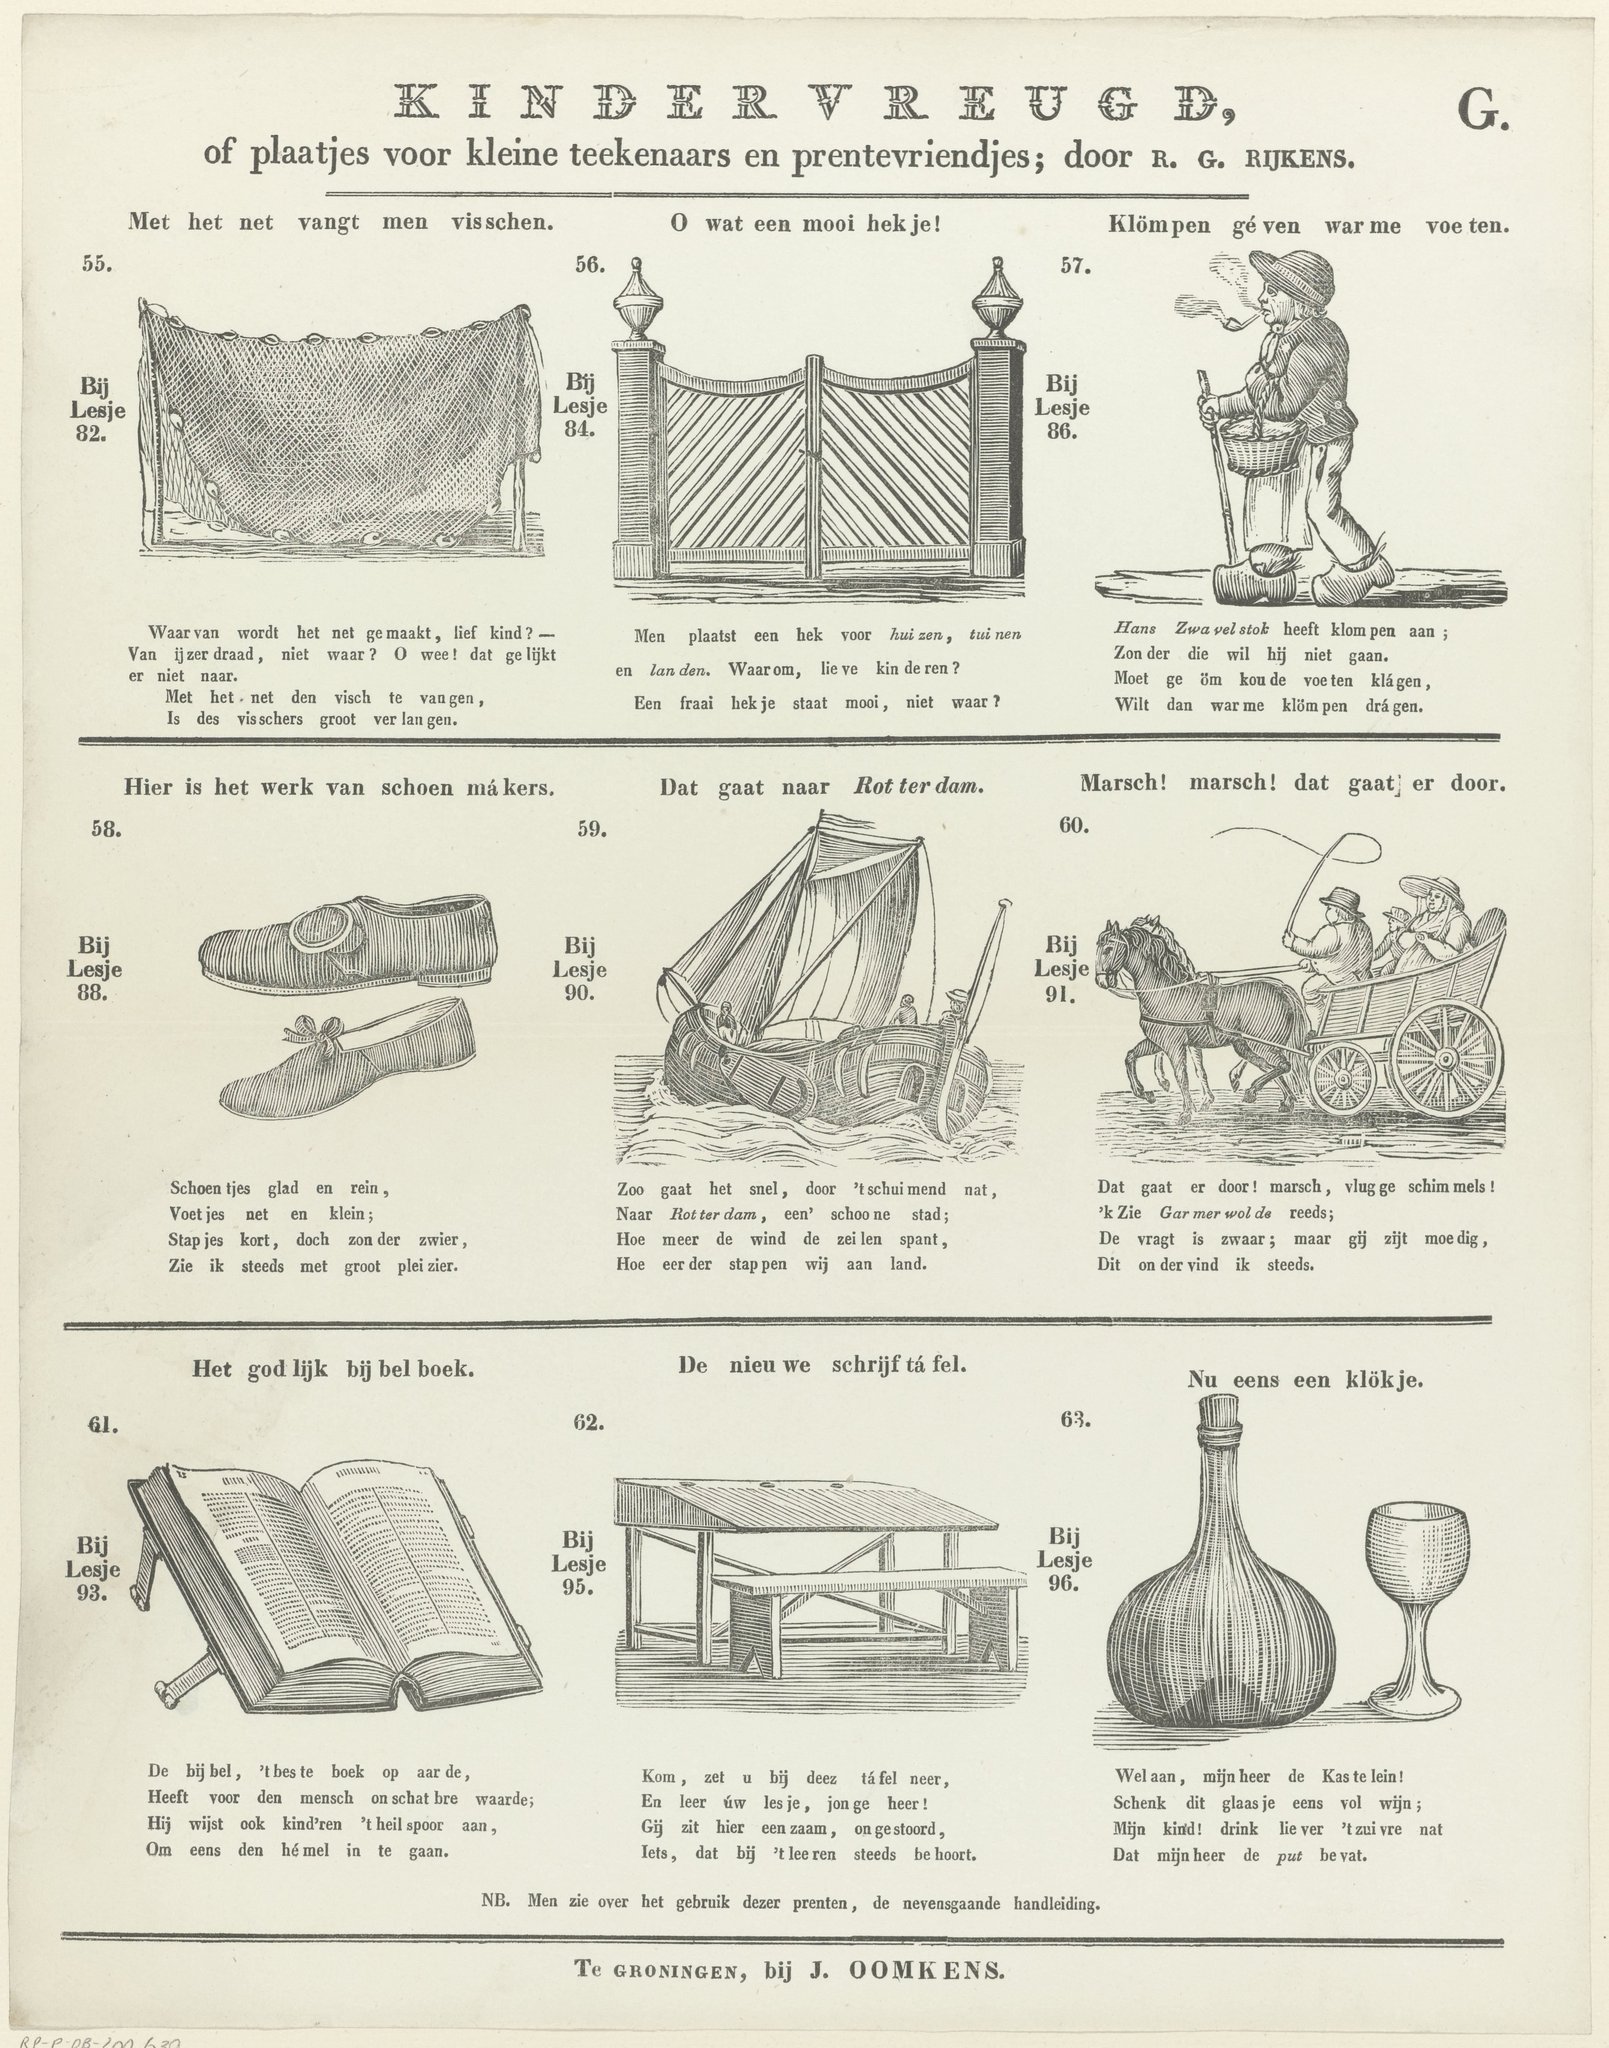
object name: popular print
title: Kindervreugd / of plaatjes voor kleine teekenaars en prentevriendjes; door R. G. Rijkens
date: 1808-1844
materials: paper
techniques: letterpress printing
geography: groningen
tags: writing-table, writing-desk, fishing net, fence, wall, paling, shoes, sandals, education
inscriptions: collector's mark: Lugt 2760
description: Blad met 9 illustraties (genummerd 55-63) bij leesboekjes van R.G. Rijkens. Elk plaatje hoort bij een lesje uit de boekjes "Natuurlijke Lees-Leerwijze". Weergegeven zijn ondermeer een visnet, een hek, schoenen en een schrijftafel. Boven elke afbeelding een nummer en een titel en onder elke afbeelding een vierregelig vers. Links van elke afbeelding staat vermeld bij welke les het plaatje hoort. Gemerkt rechtsboven: G.